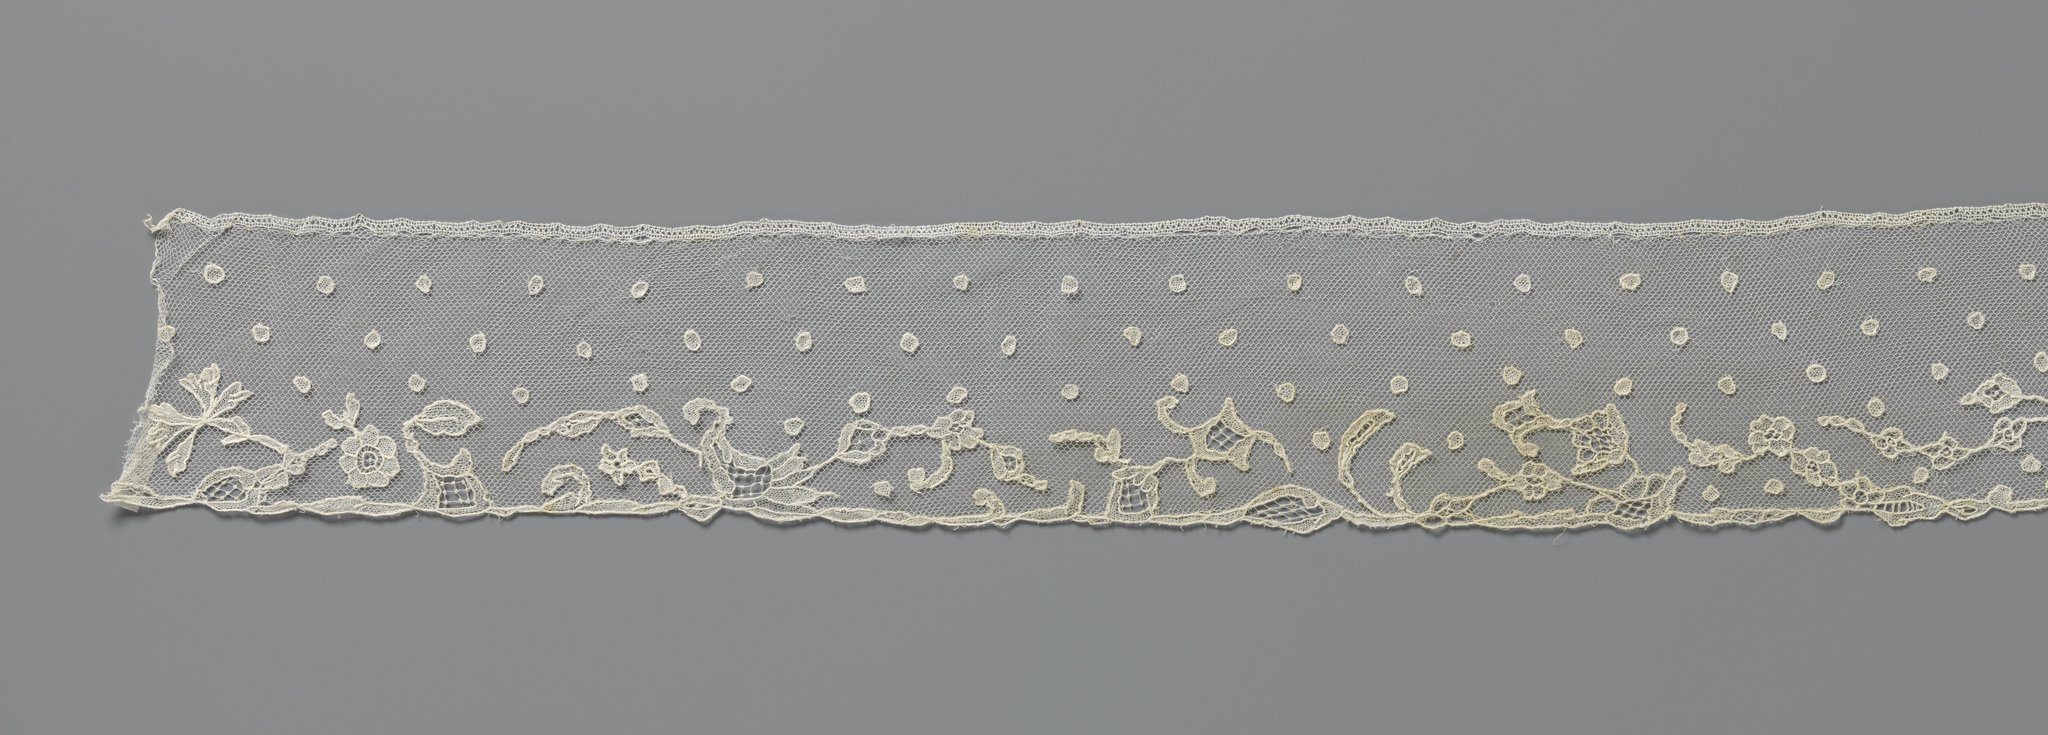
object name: strip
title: Strook applicatiekant met moesjes en verschillende bloemen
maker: Anonymous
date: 1850-1870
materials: linen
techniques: lace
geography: brussels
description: Strook naturelkleurige applicatiekant: naaldkant geappliceerd op machinale tule. Strooipatroon met grove moesjes op een fijne zeshoekige maasgrond. De flauw geschulpte onderrand komt voort uit bladertakken met bloemen in verschillende soorten en formaten. Motieven met reliëfcontouren van wijd gefestonneerde draadbundels. Siersteken in de bloemen. De bovenzijde is afgewerkt met een apart geklost bandje.